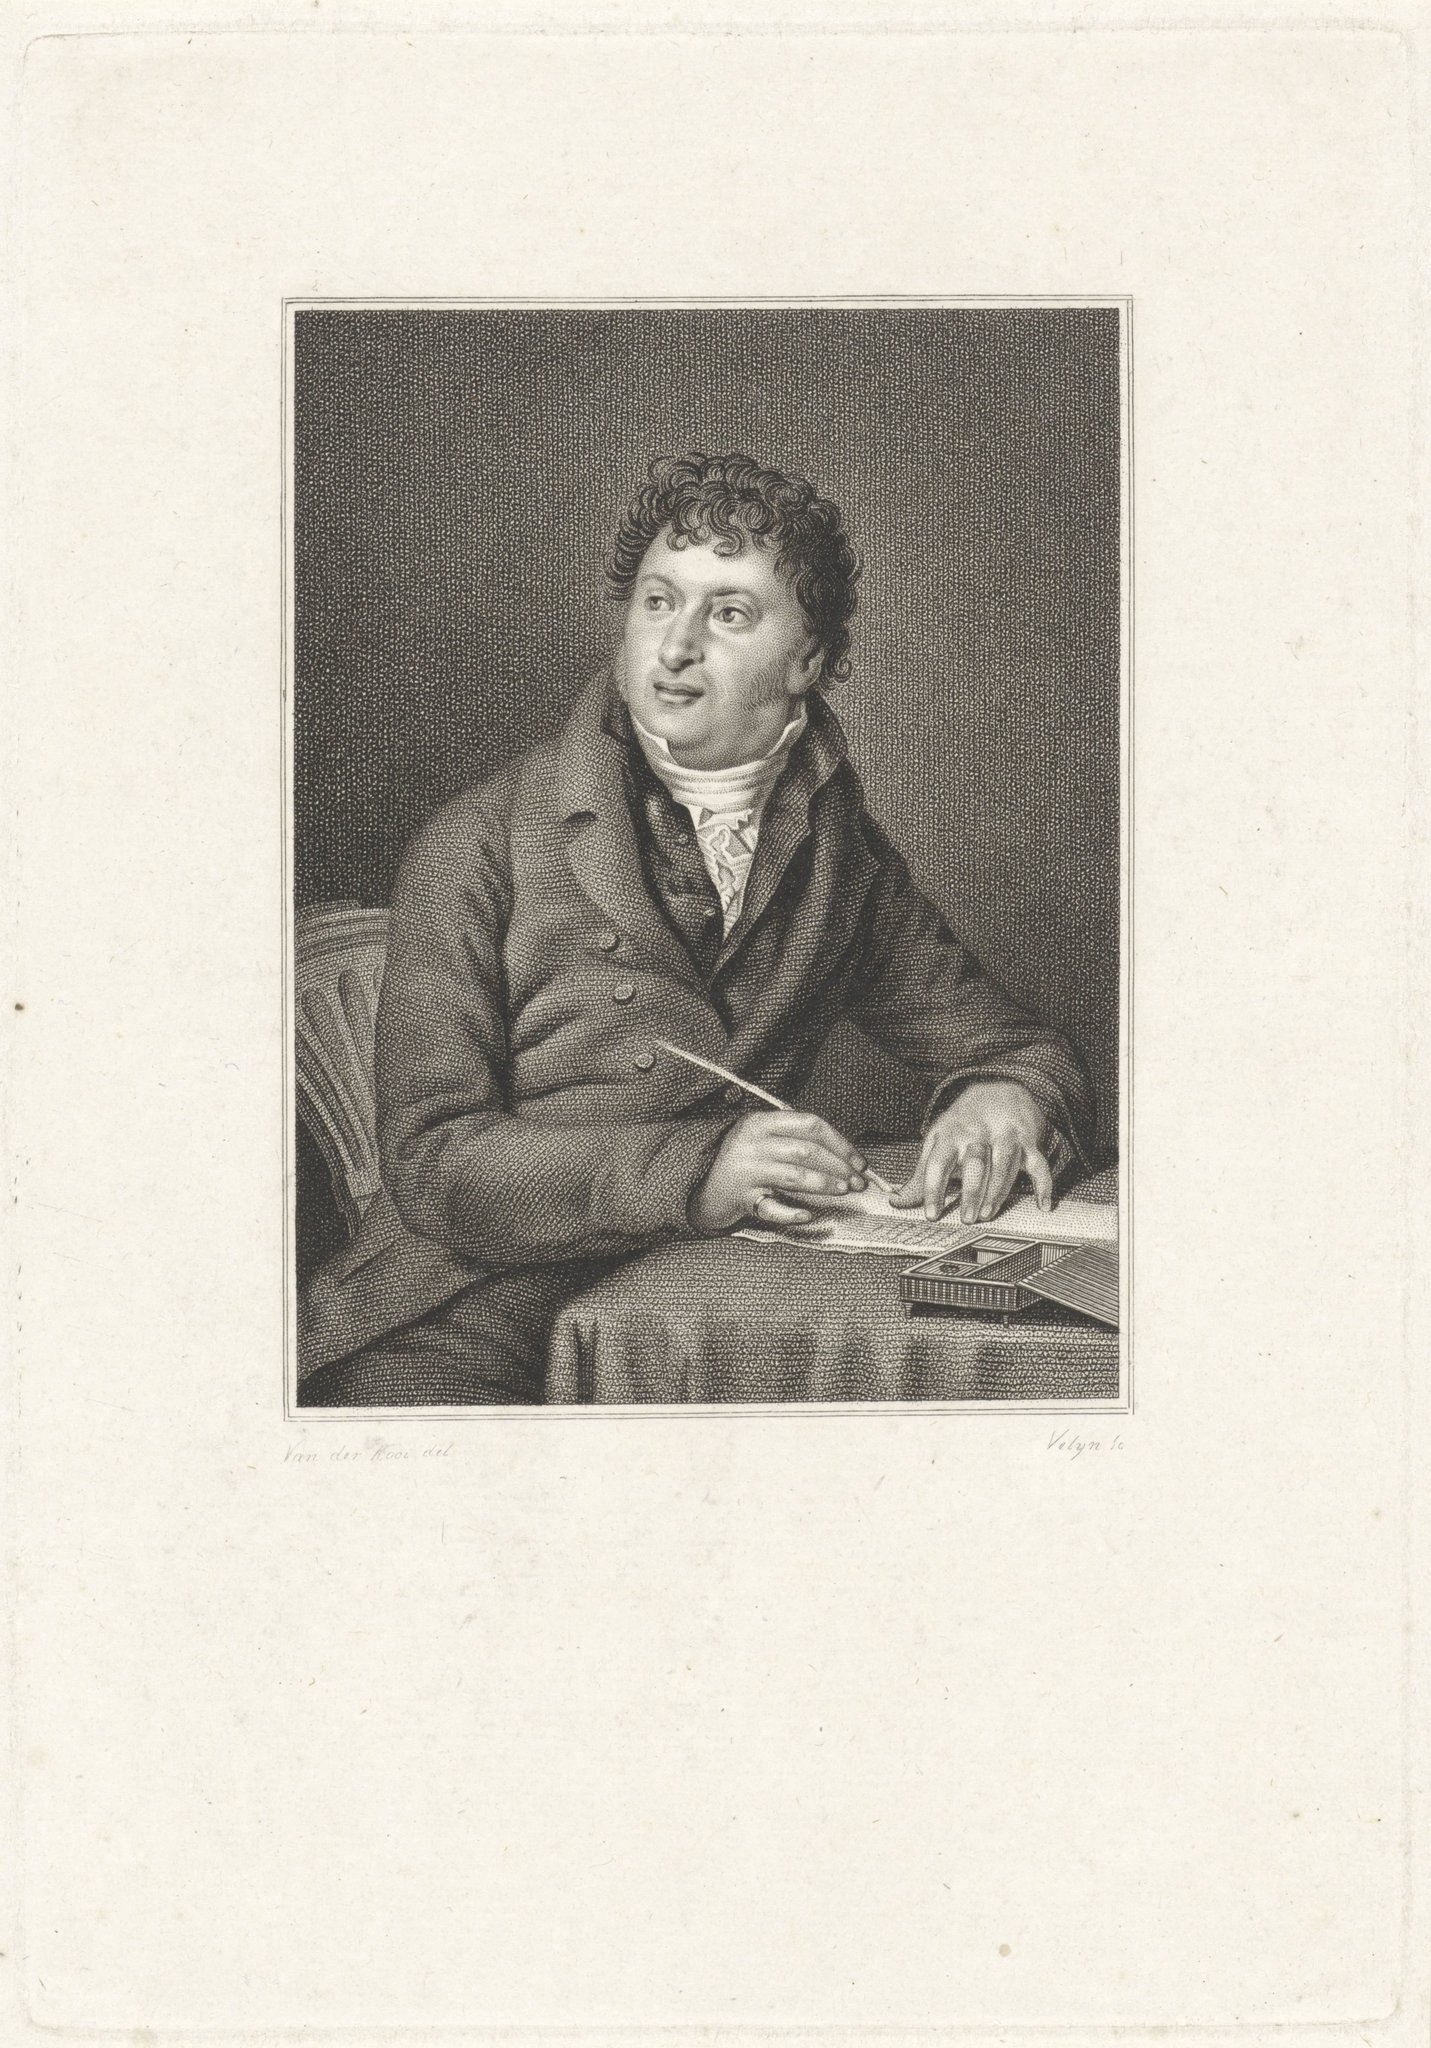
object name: print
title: Portret van Matheus van Heyningen Bosch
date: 1821-1836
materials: paper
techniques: engraving, etching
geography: netherlands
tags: matheus van heyningen bosch, writing accessories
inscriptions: collector's mark: Lugt 2228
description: Portret van de Nederlandse schrijver Matheus van Heyningen Bosch.